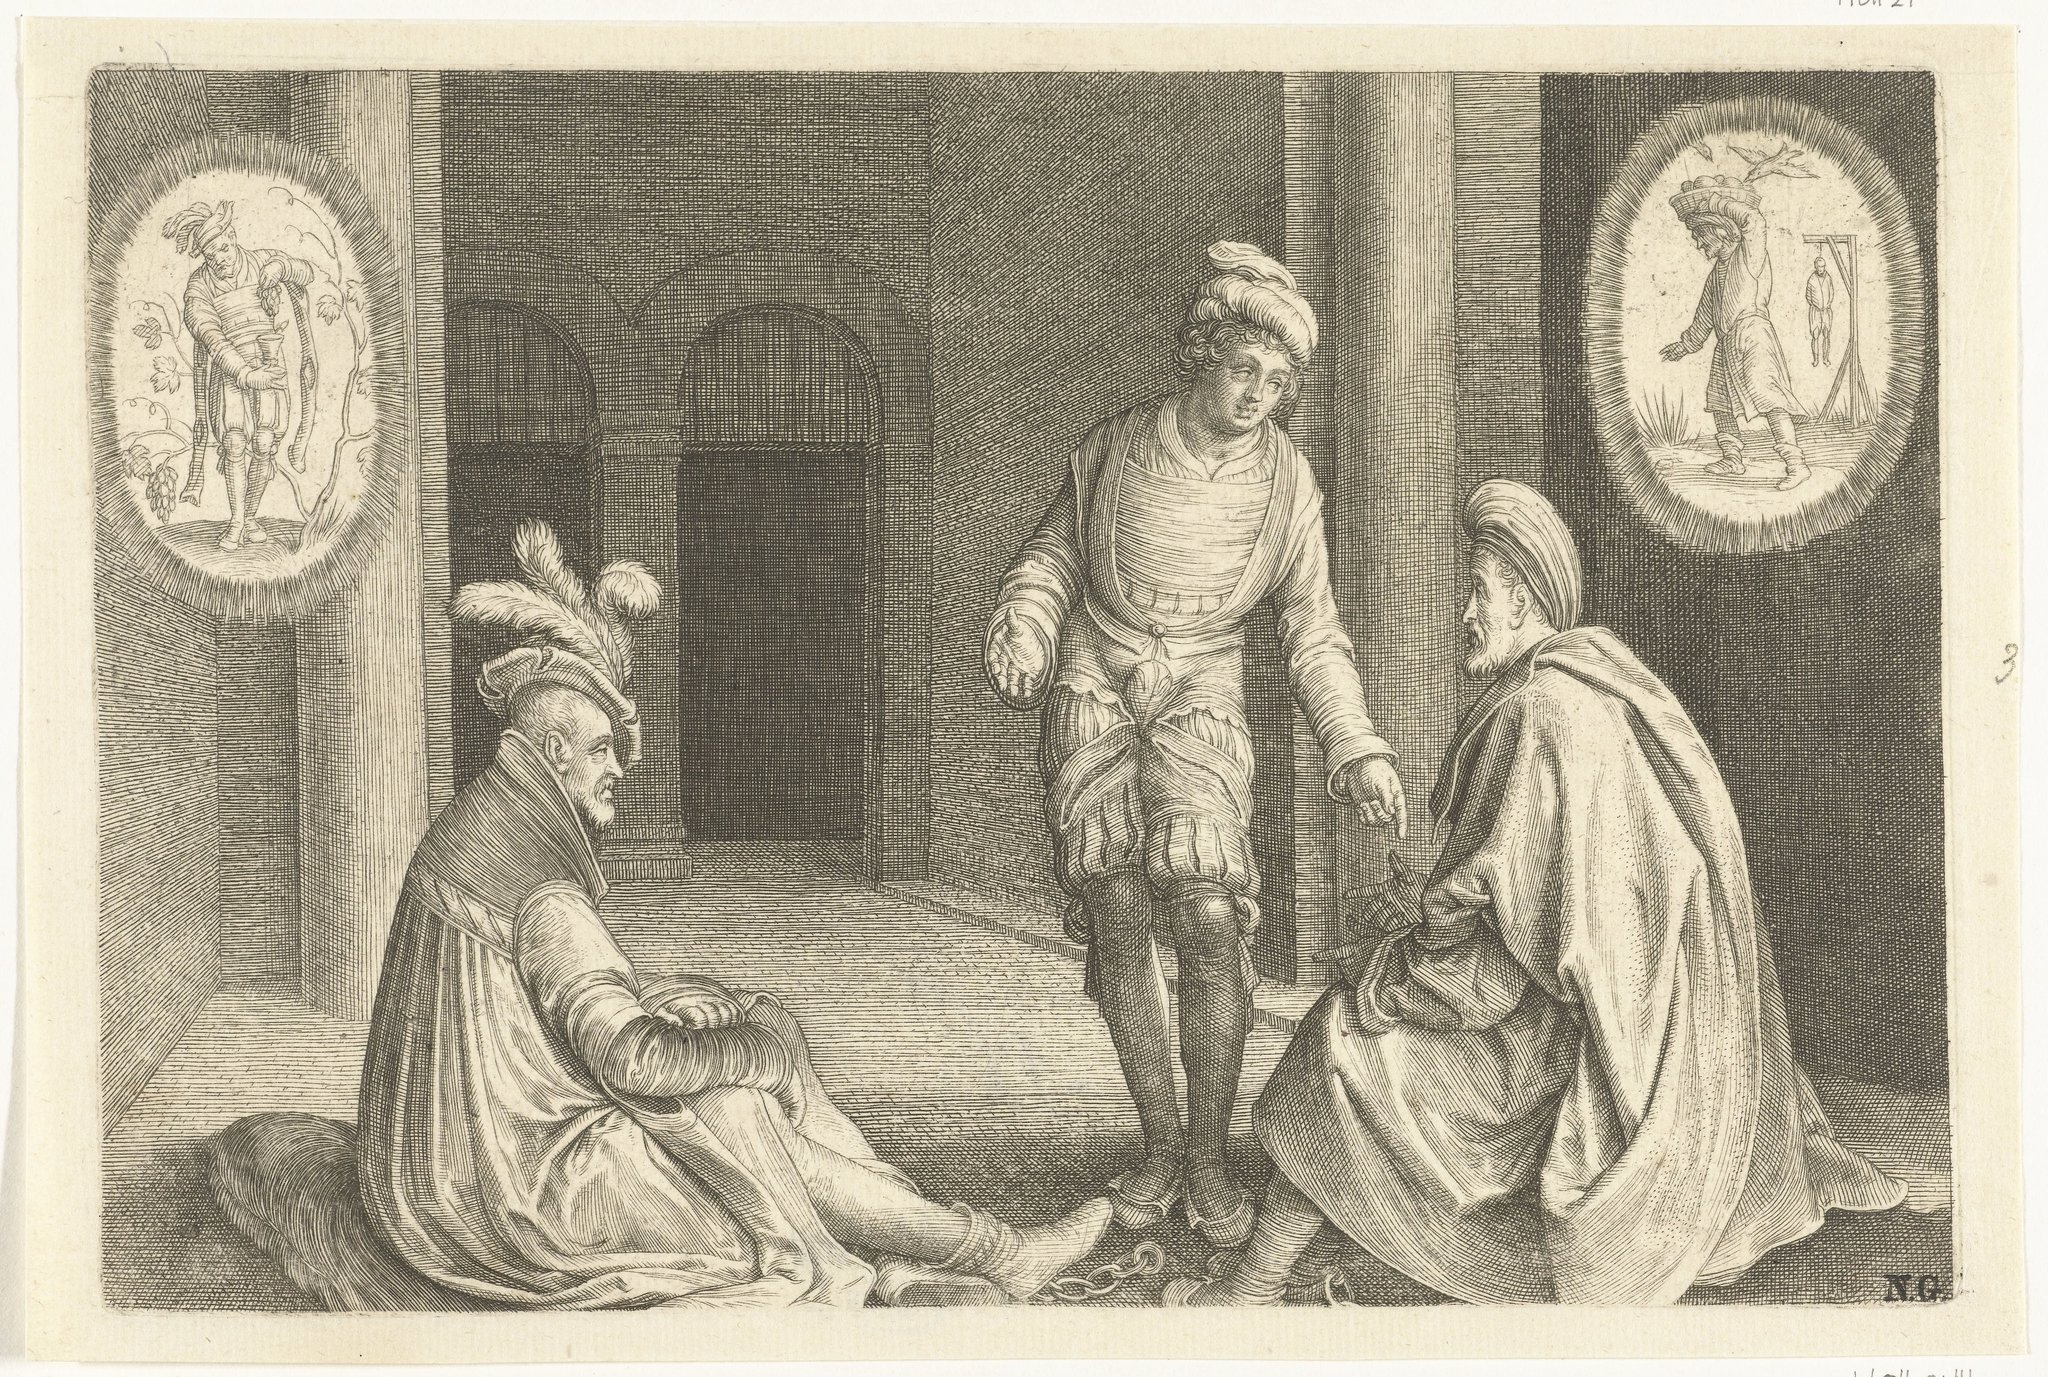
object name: print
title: Jozef legt dromen uit van schenker en bakker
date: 1628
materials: paper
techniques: engraving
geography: netherlands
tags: joseph interpreting the dreams of the butler and the baker (the two dreams combined)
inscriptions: collector's mark: Lugt 2228, collector's mark: Lugt 1967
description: Prent uit serie van zes prenten met het verhaal van Jozef. De serie is geïnspireerd op een vergelijkbare reeks van Lucas van Leyden.